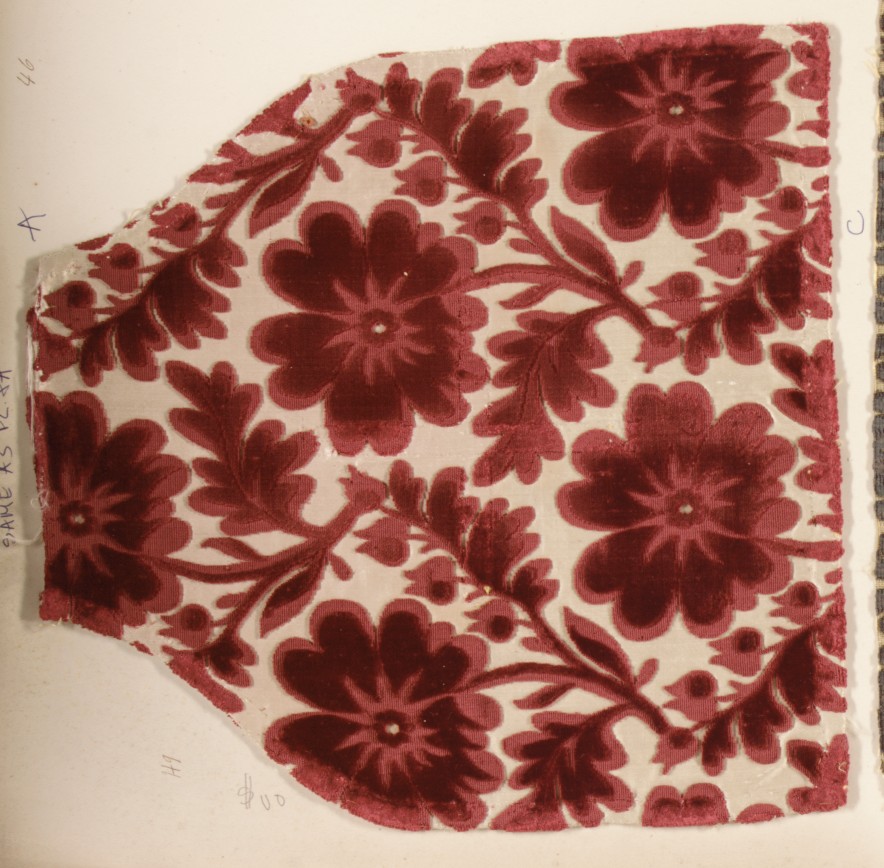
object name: fragment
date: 1667-1700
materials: silk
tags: flowers,leaves